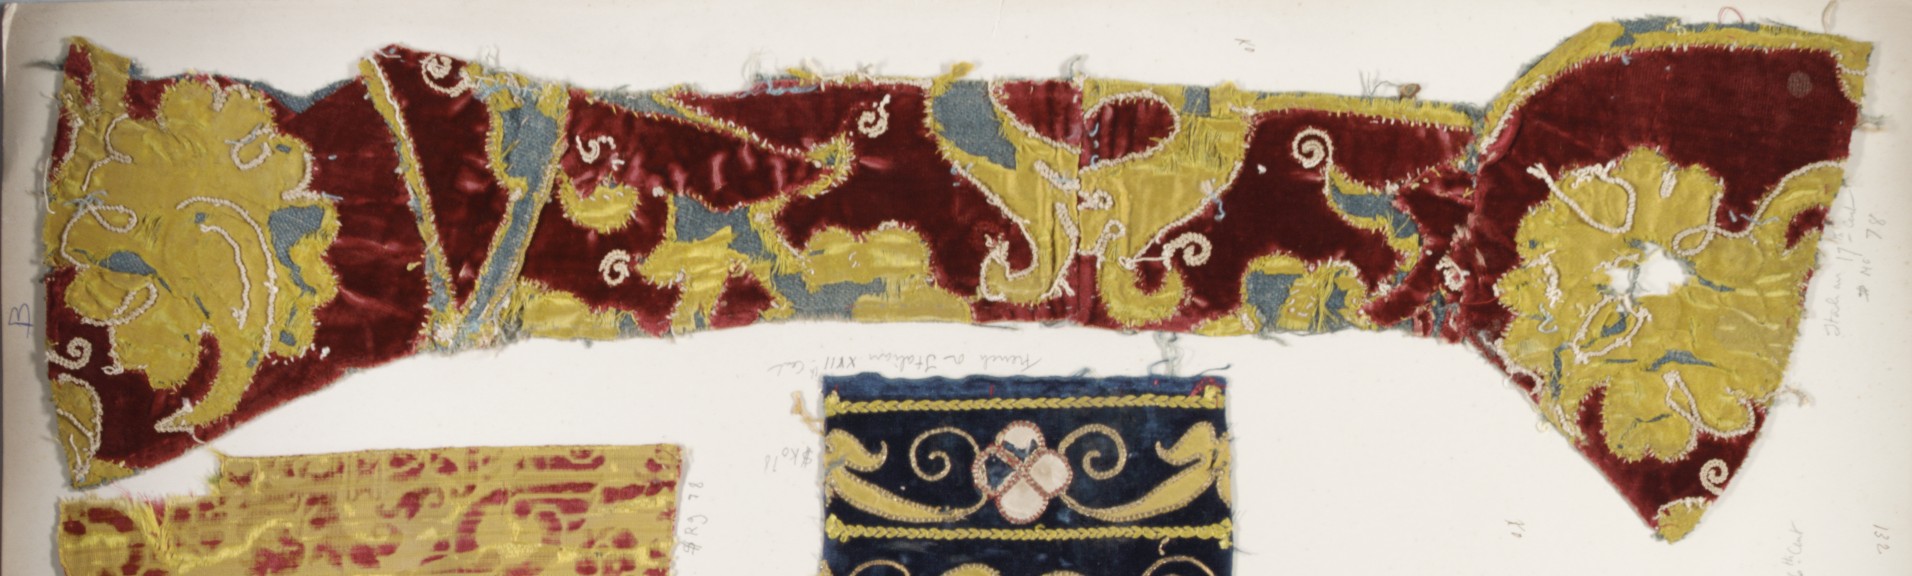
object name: fragment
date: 1601-1700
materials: silk